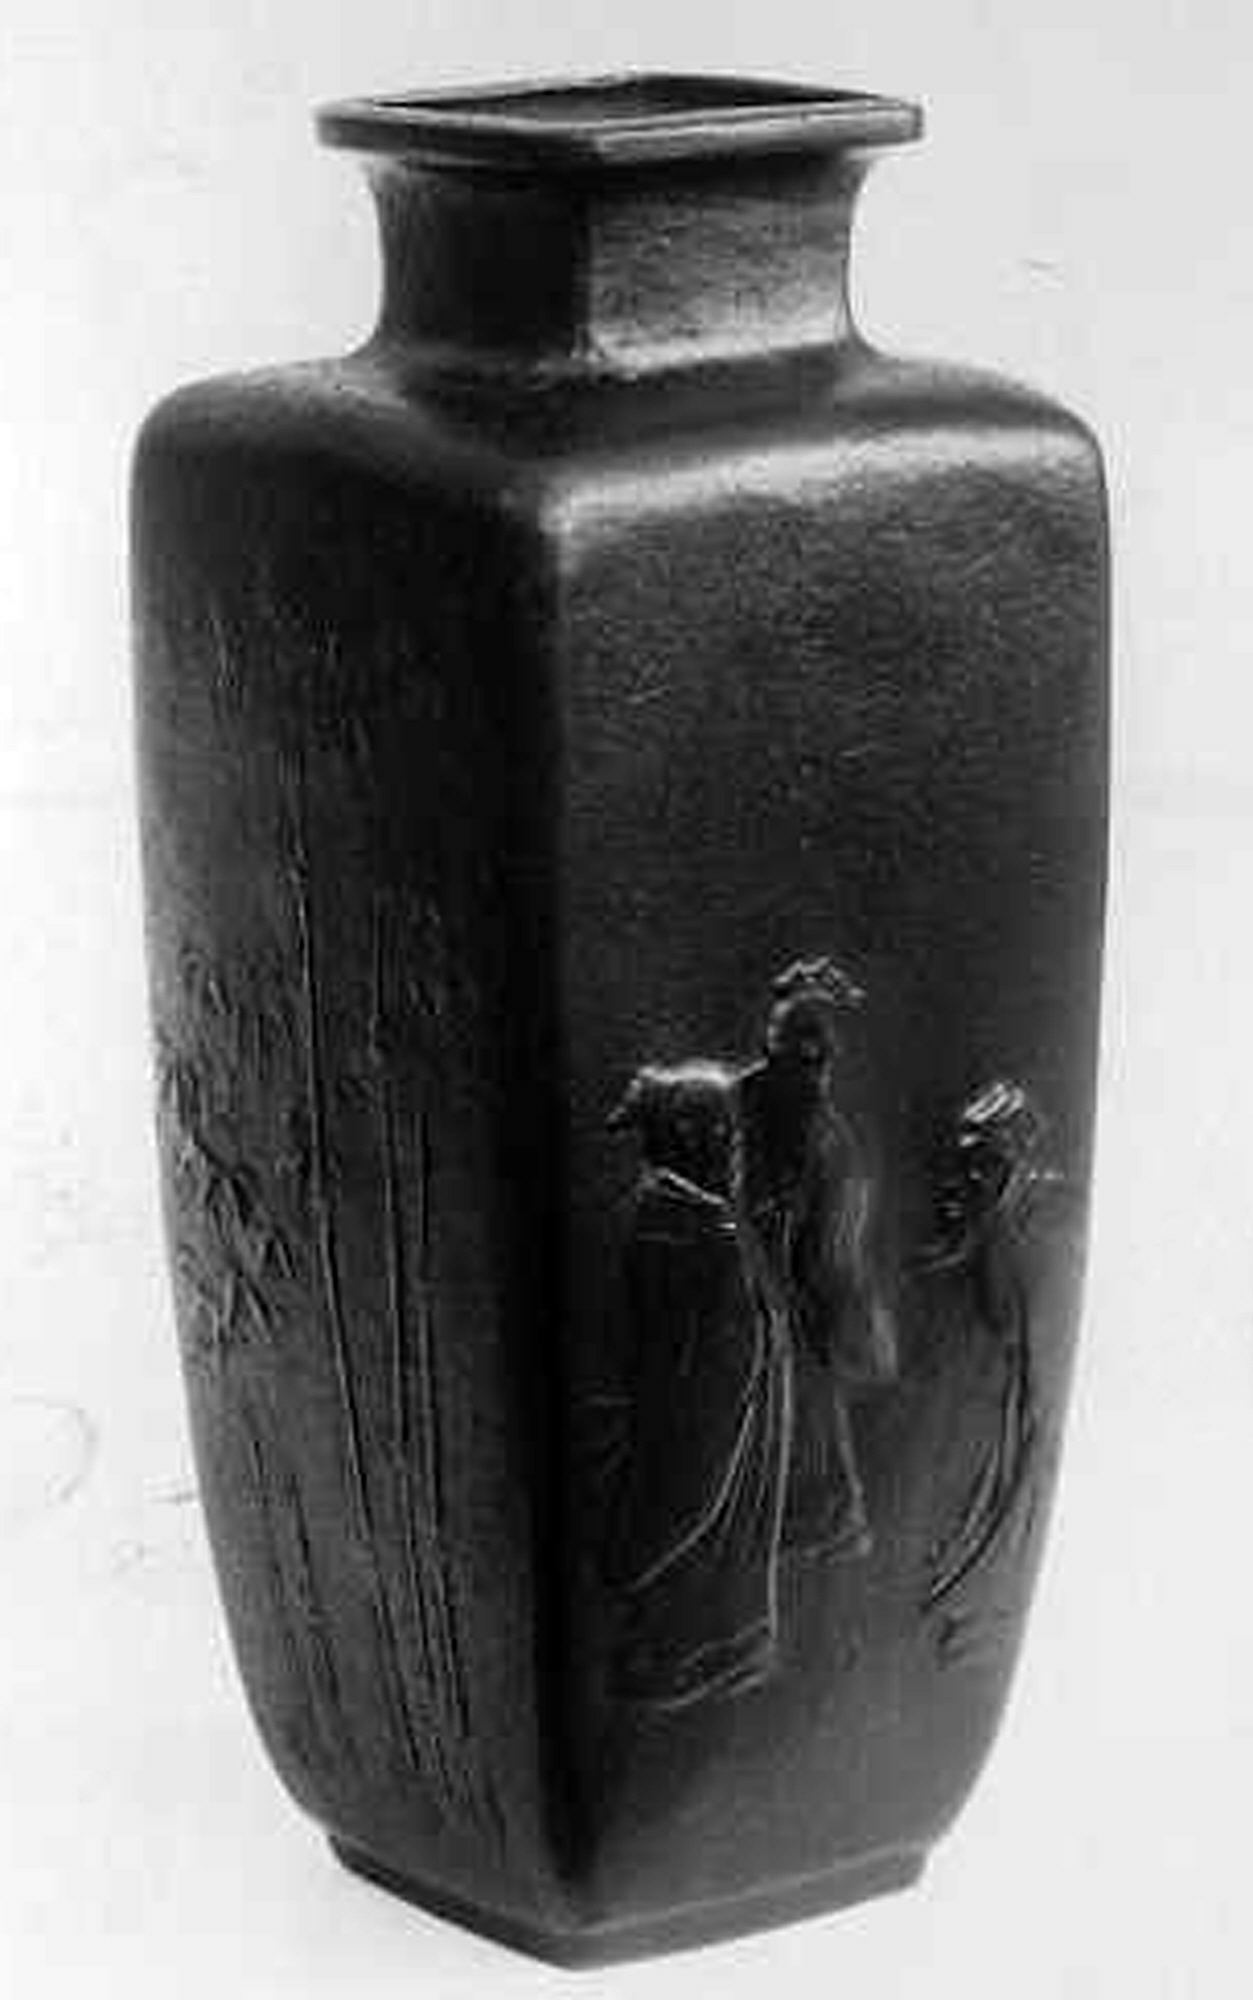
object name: vase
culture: japanese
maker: munemitsu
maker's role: artist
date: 1801-1900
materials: iron